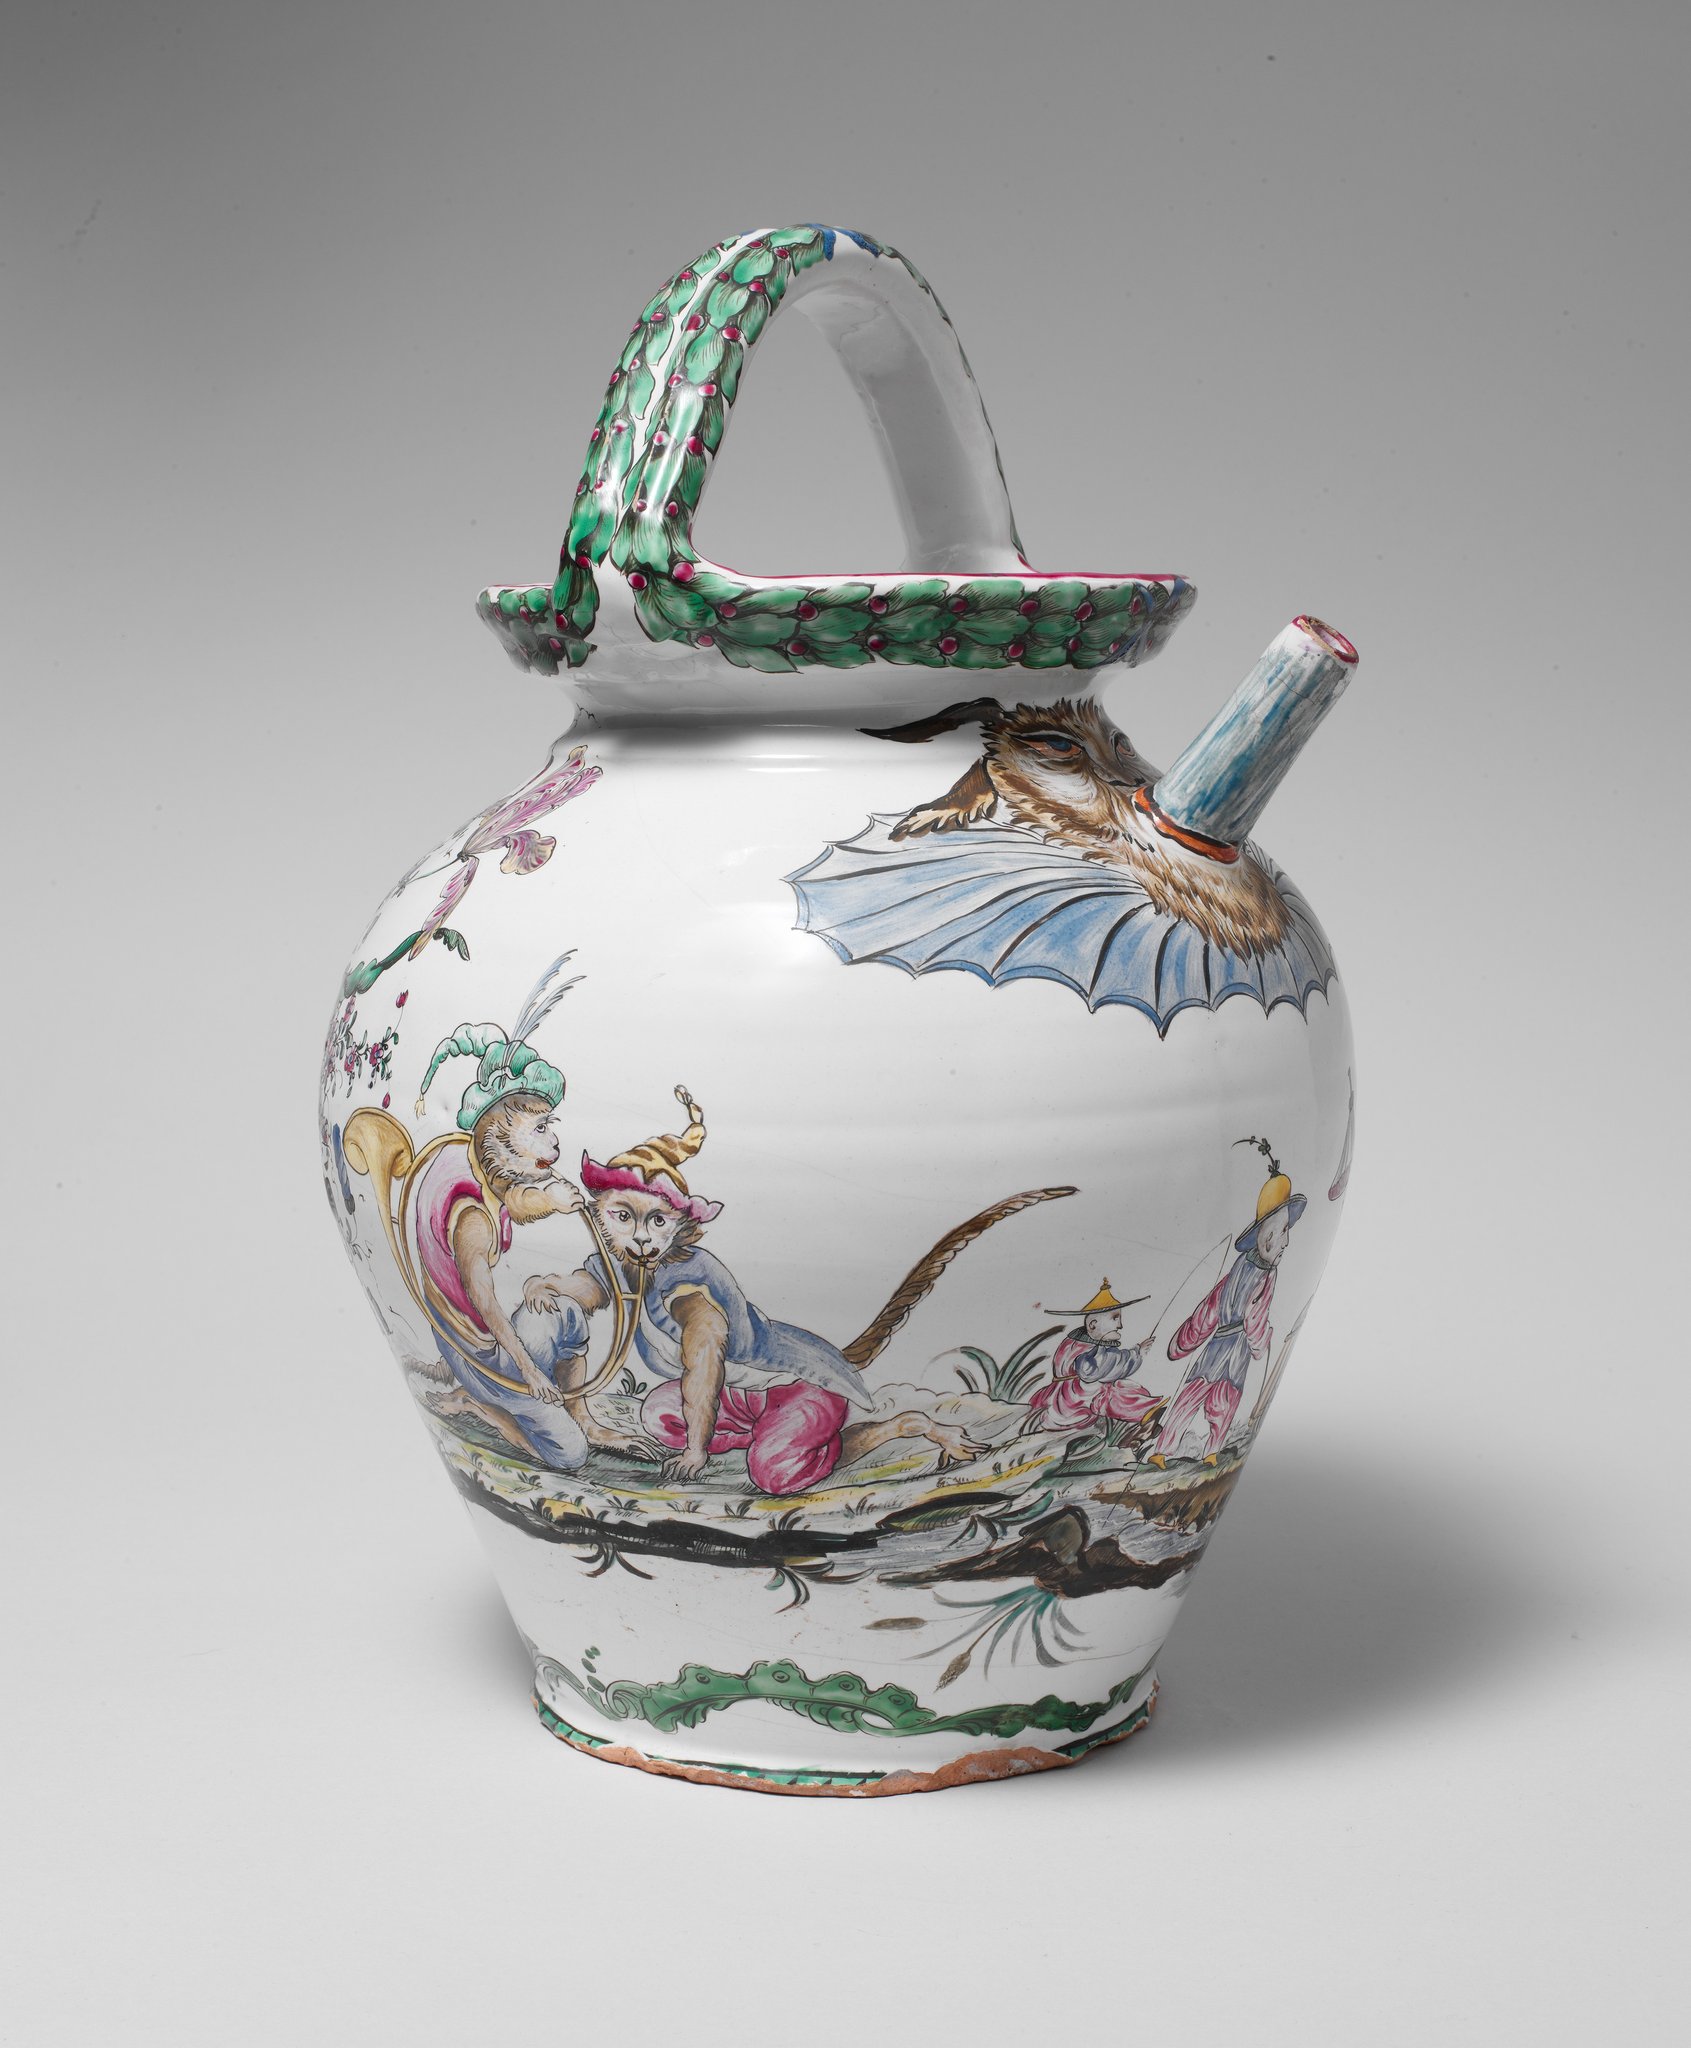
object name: water jar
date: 1765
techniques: maiolica, glazing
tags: chinoiserie,men,horns,monkeys